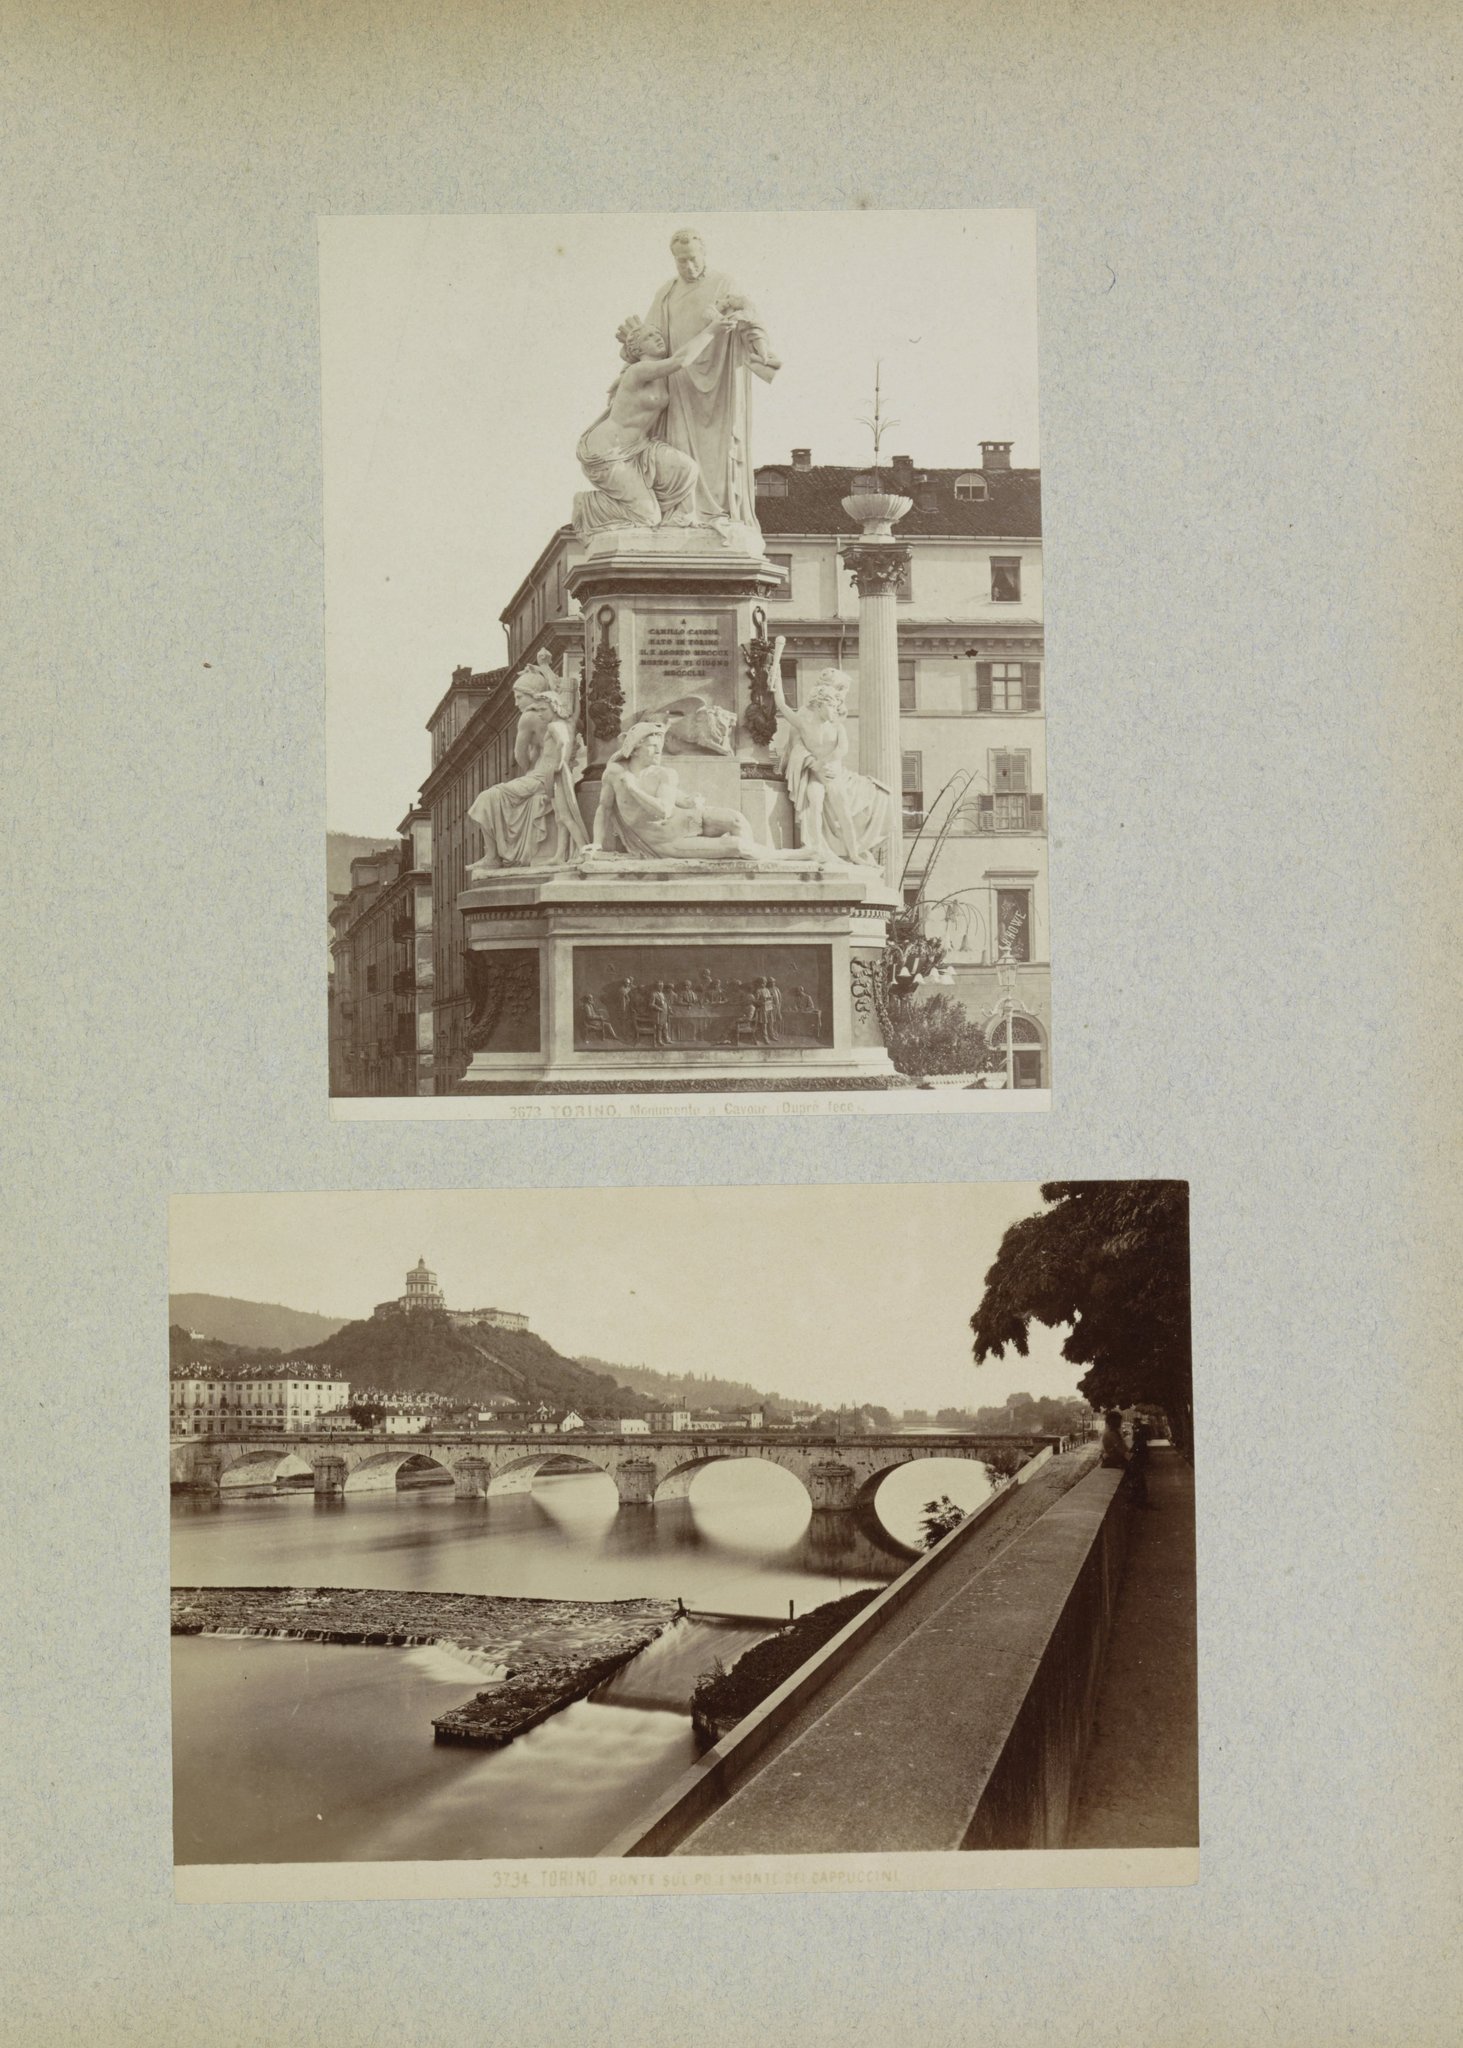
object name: photograph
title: 3734 Torino Ponte sul Po Monte dei Cappuccini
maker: Anonymous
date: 1885-1900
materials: paper, photographic support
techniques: albumen print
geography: france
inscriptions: caption: ‘3734 Torino Ponte sul Po Monte dei Cappuccini’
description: Brug over de Po en de Monte dei Cappuccini met de Chiesa di Santa Maria del Monte, Turijn (Torino), Italië